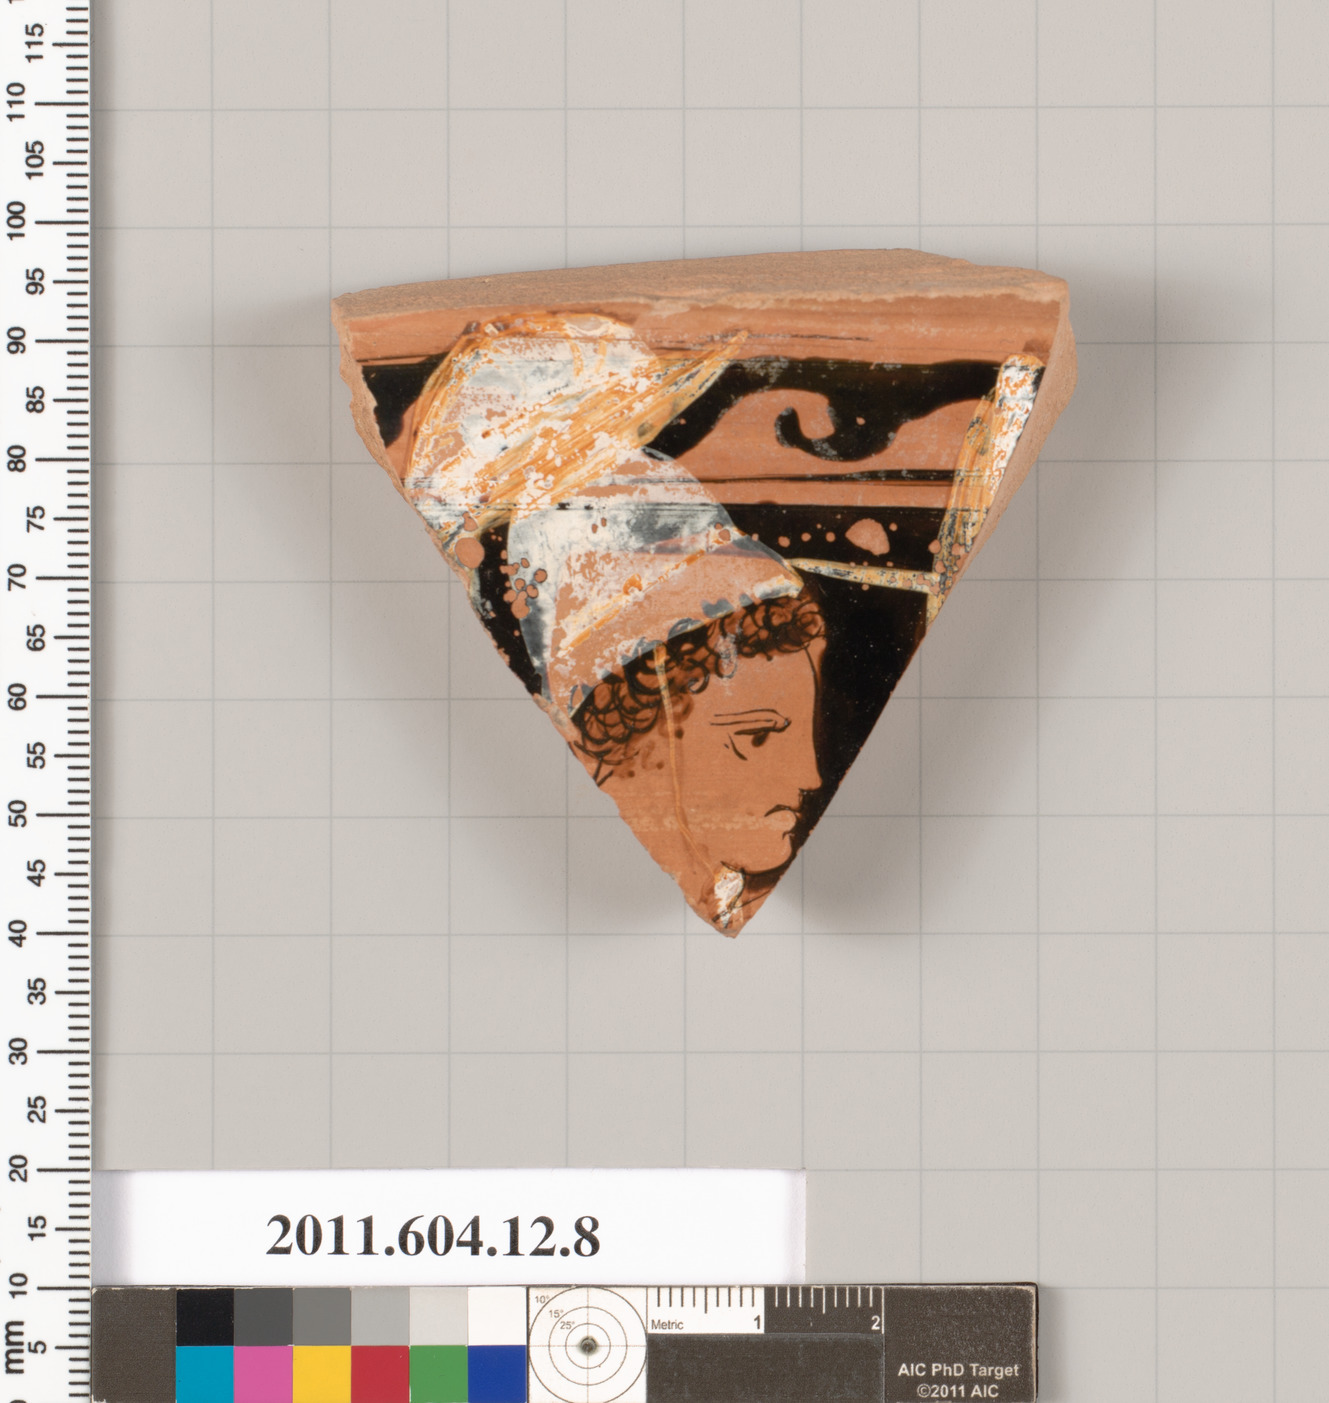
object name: krater fragment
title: Terracotta fragment of a krater (deep bowl)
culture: greek, south italian, apulian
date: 350-301 BCE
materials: terracotta